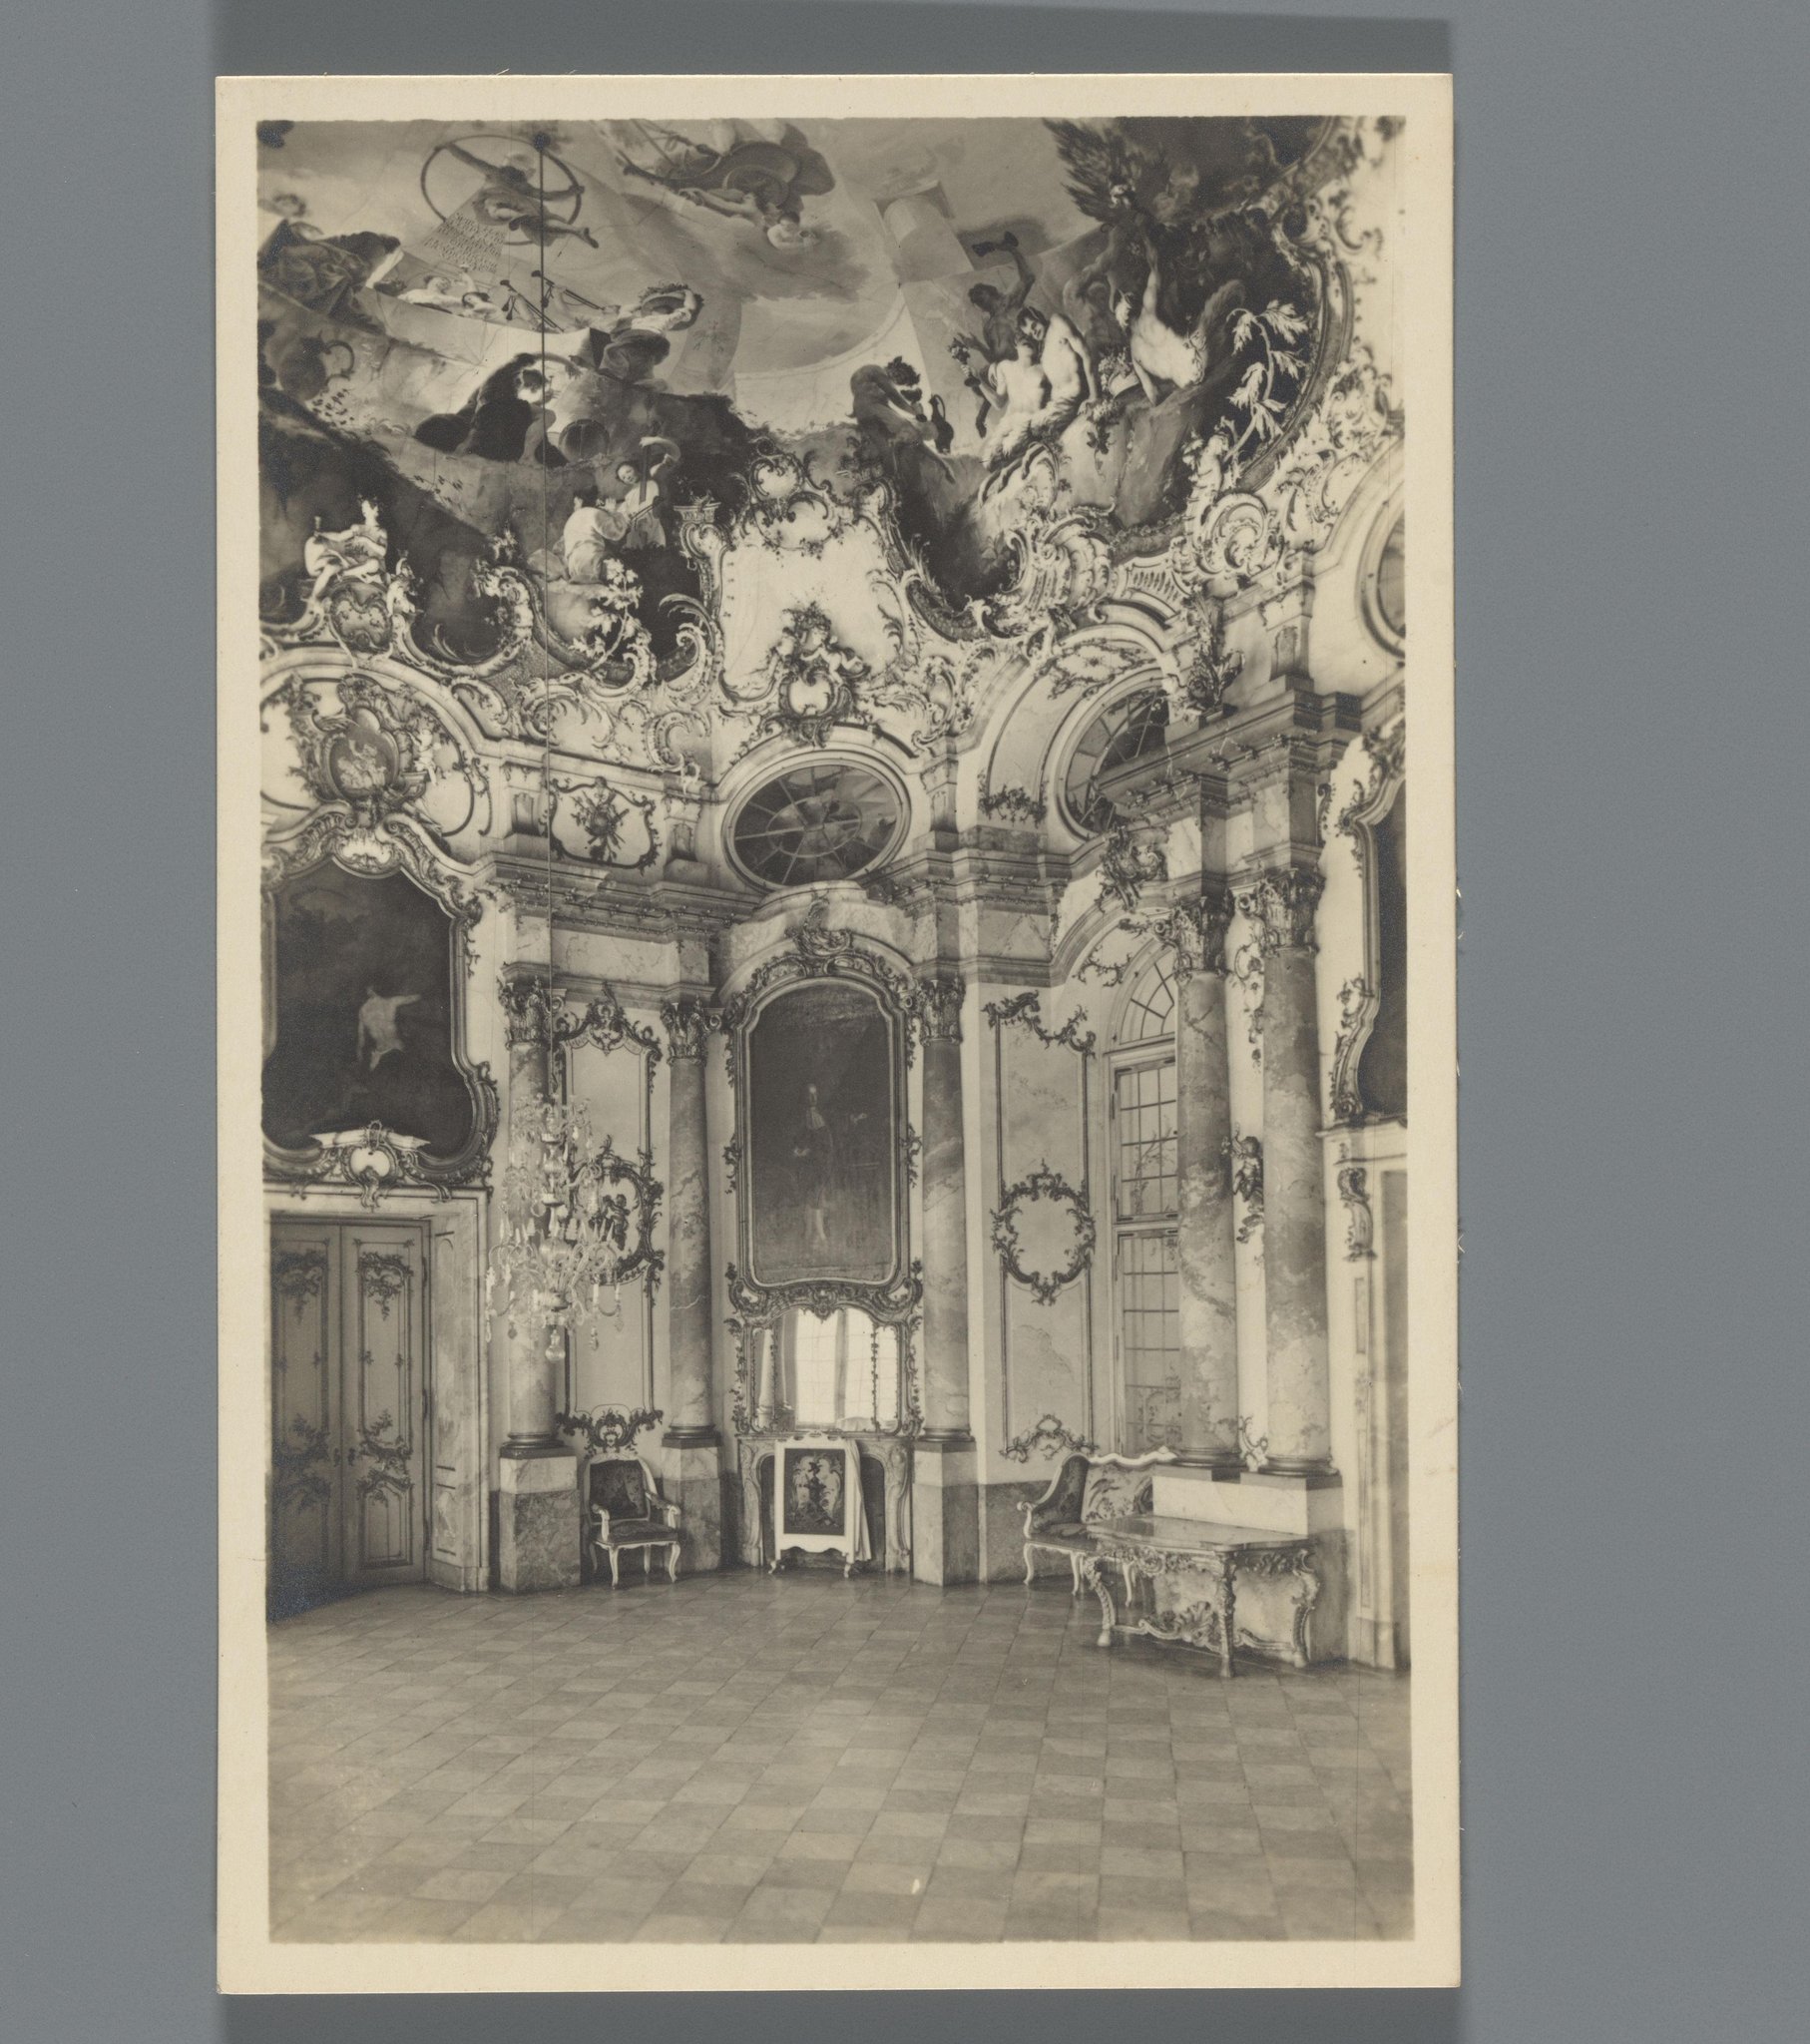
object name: photograph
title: Zaal in slot Bruchsal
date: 1905-1924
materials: paper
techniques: gelatin silver print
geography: bruchsal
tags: castle - aa - civic architecture: inside